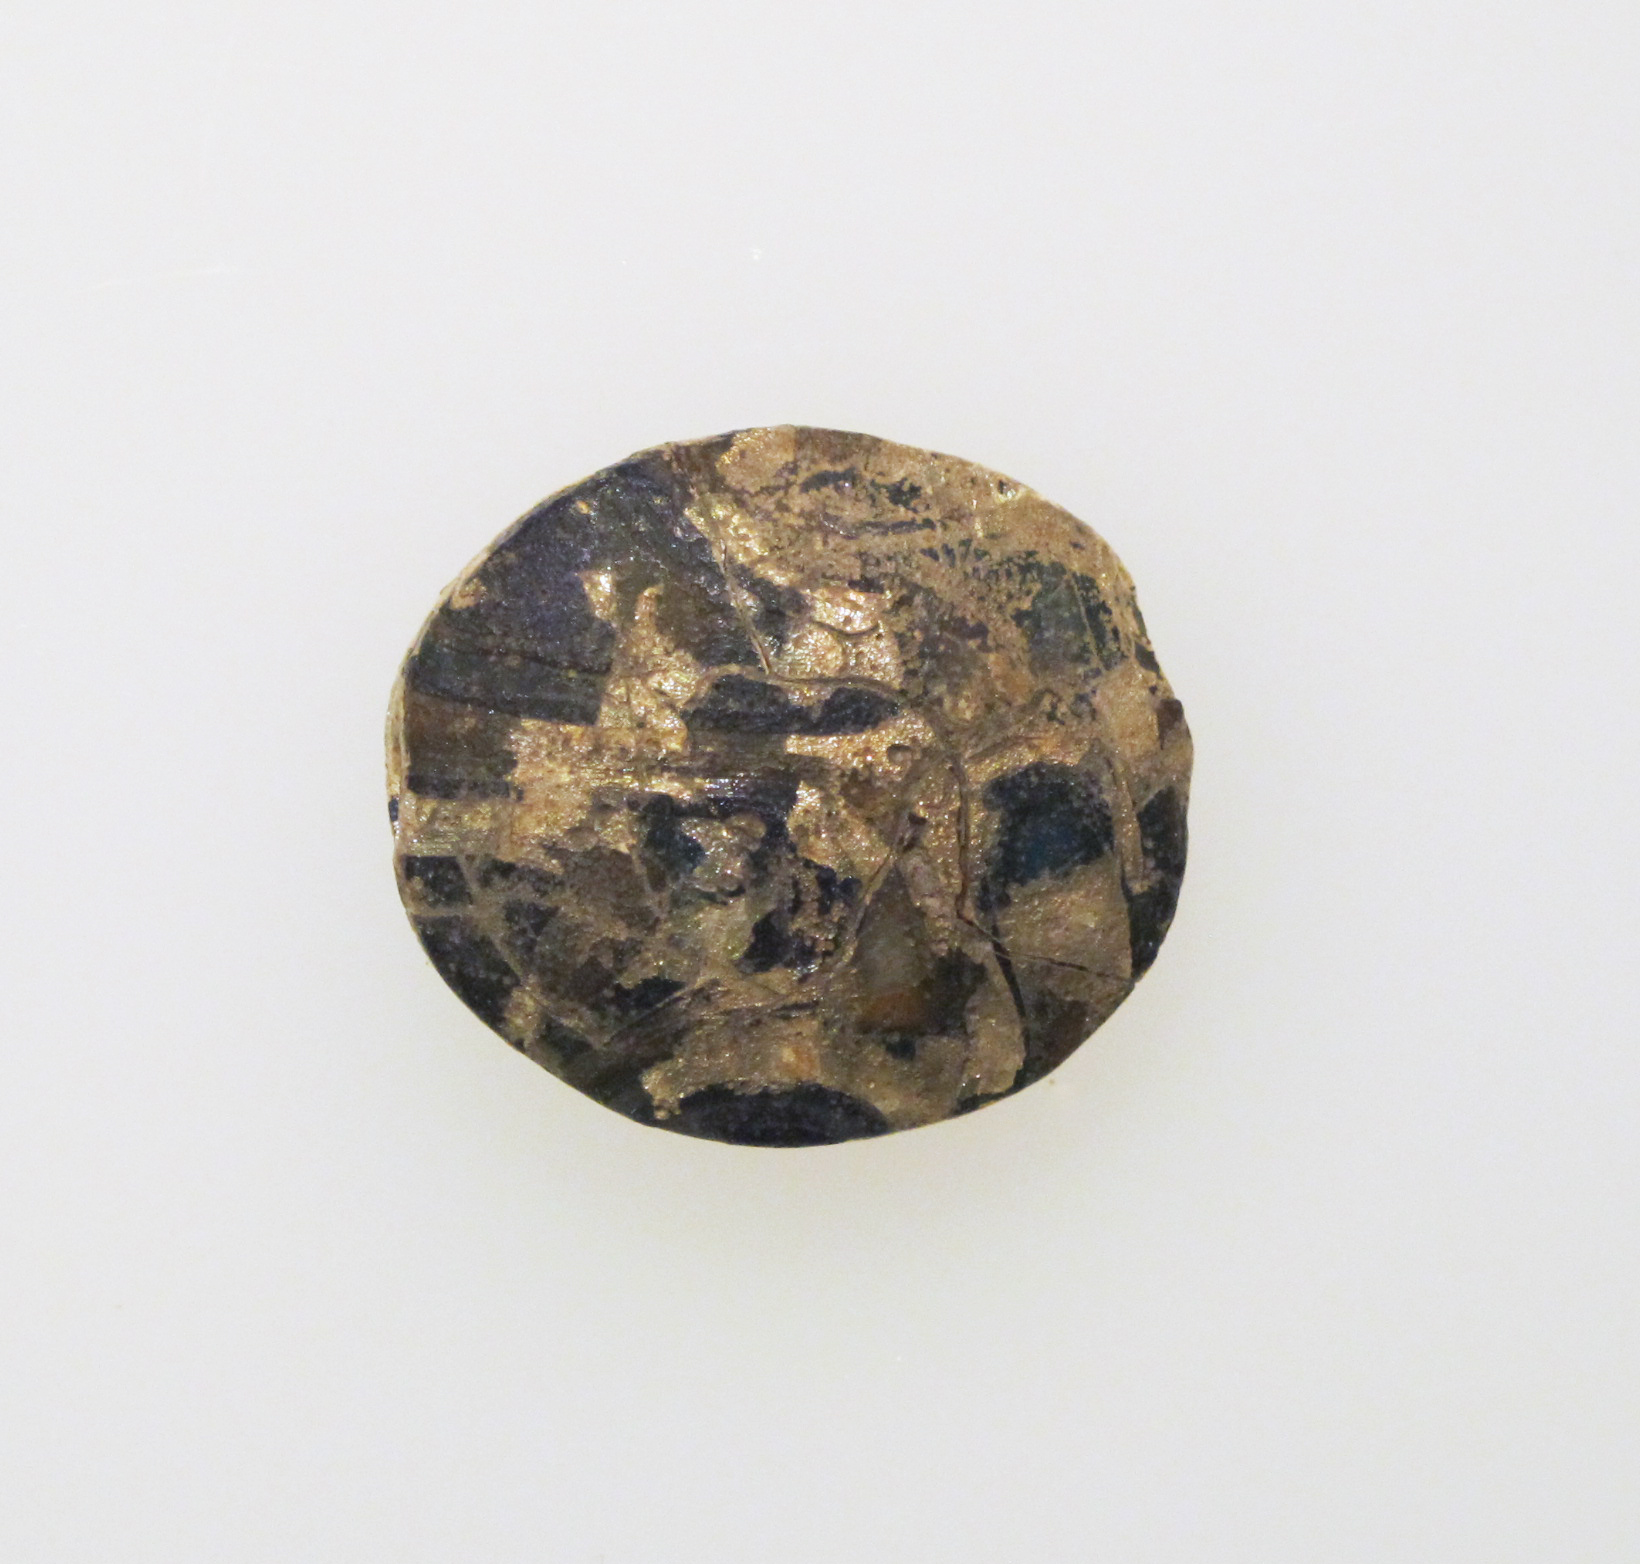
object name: pinhead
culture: roman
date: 670 BCE-330 CE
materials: glass